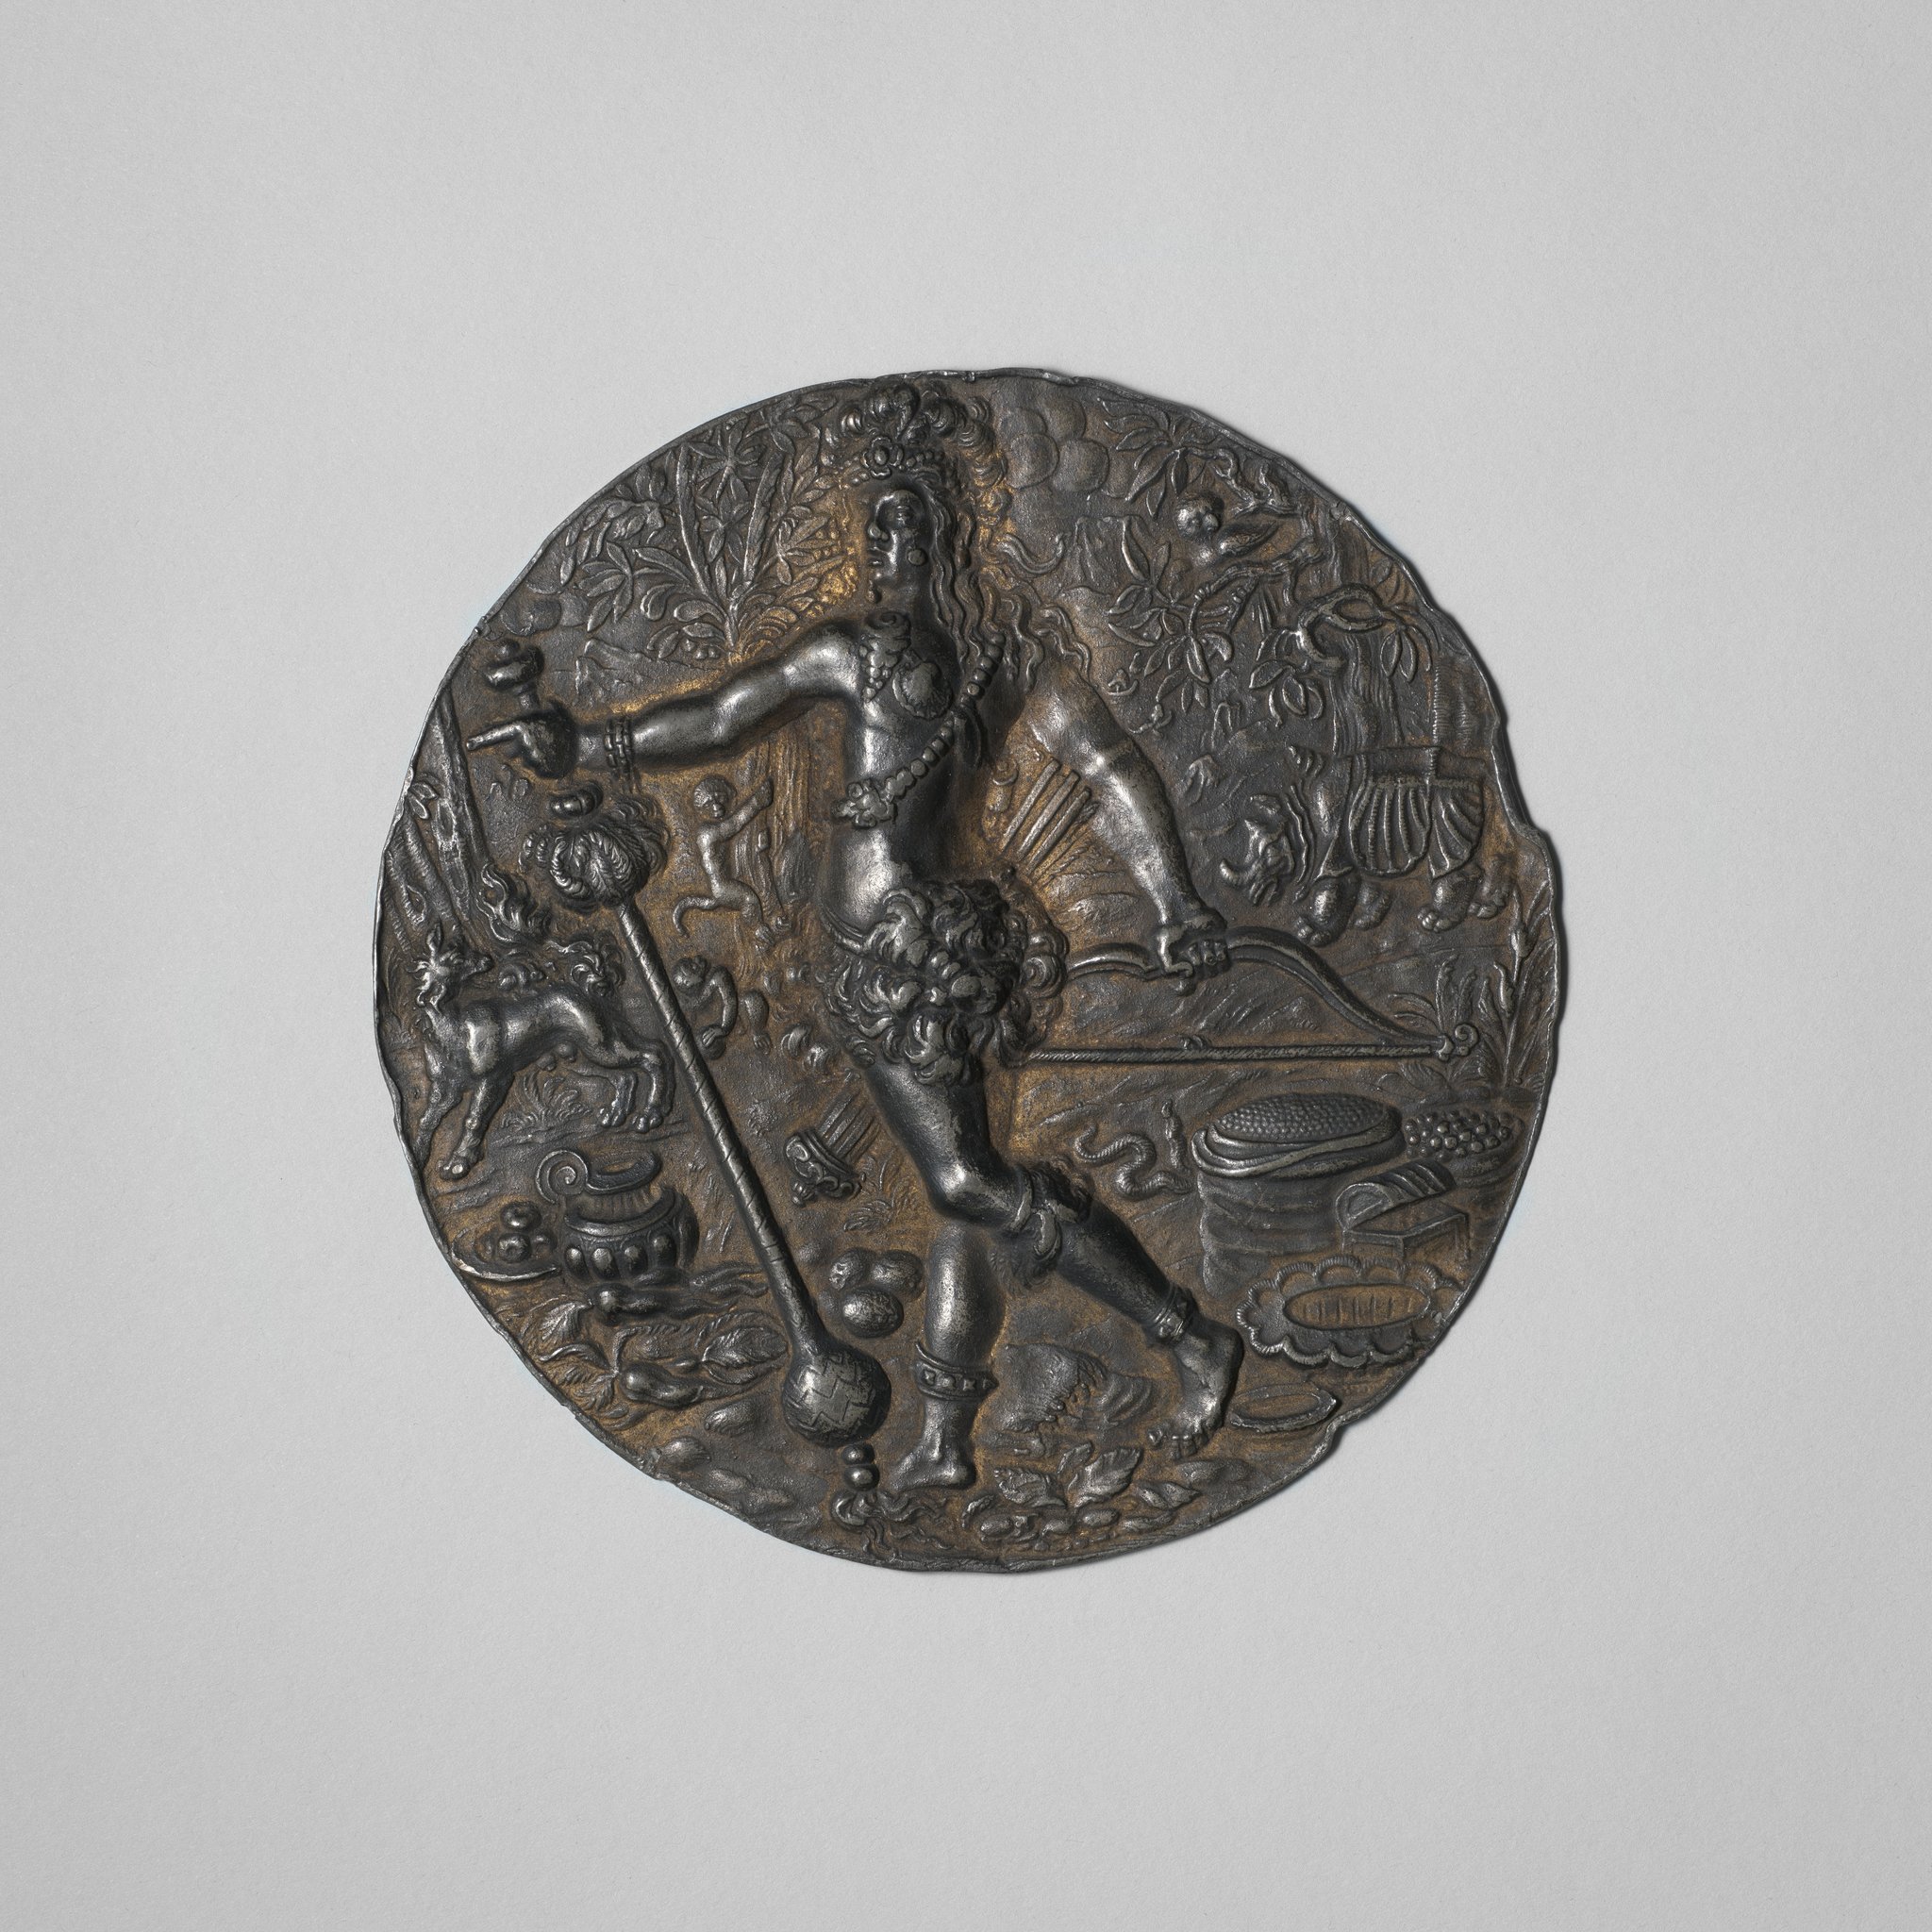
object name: plaquette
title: Personification of America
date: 1580-1590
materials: lead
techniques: gilding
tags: bow and arrow,men